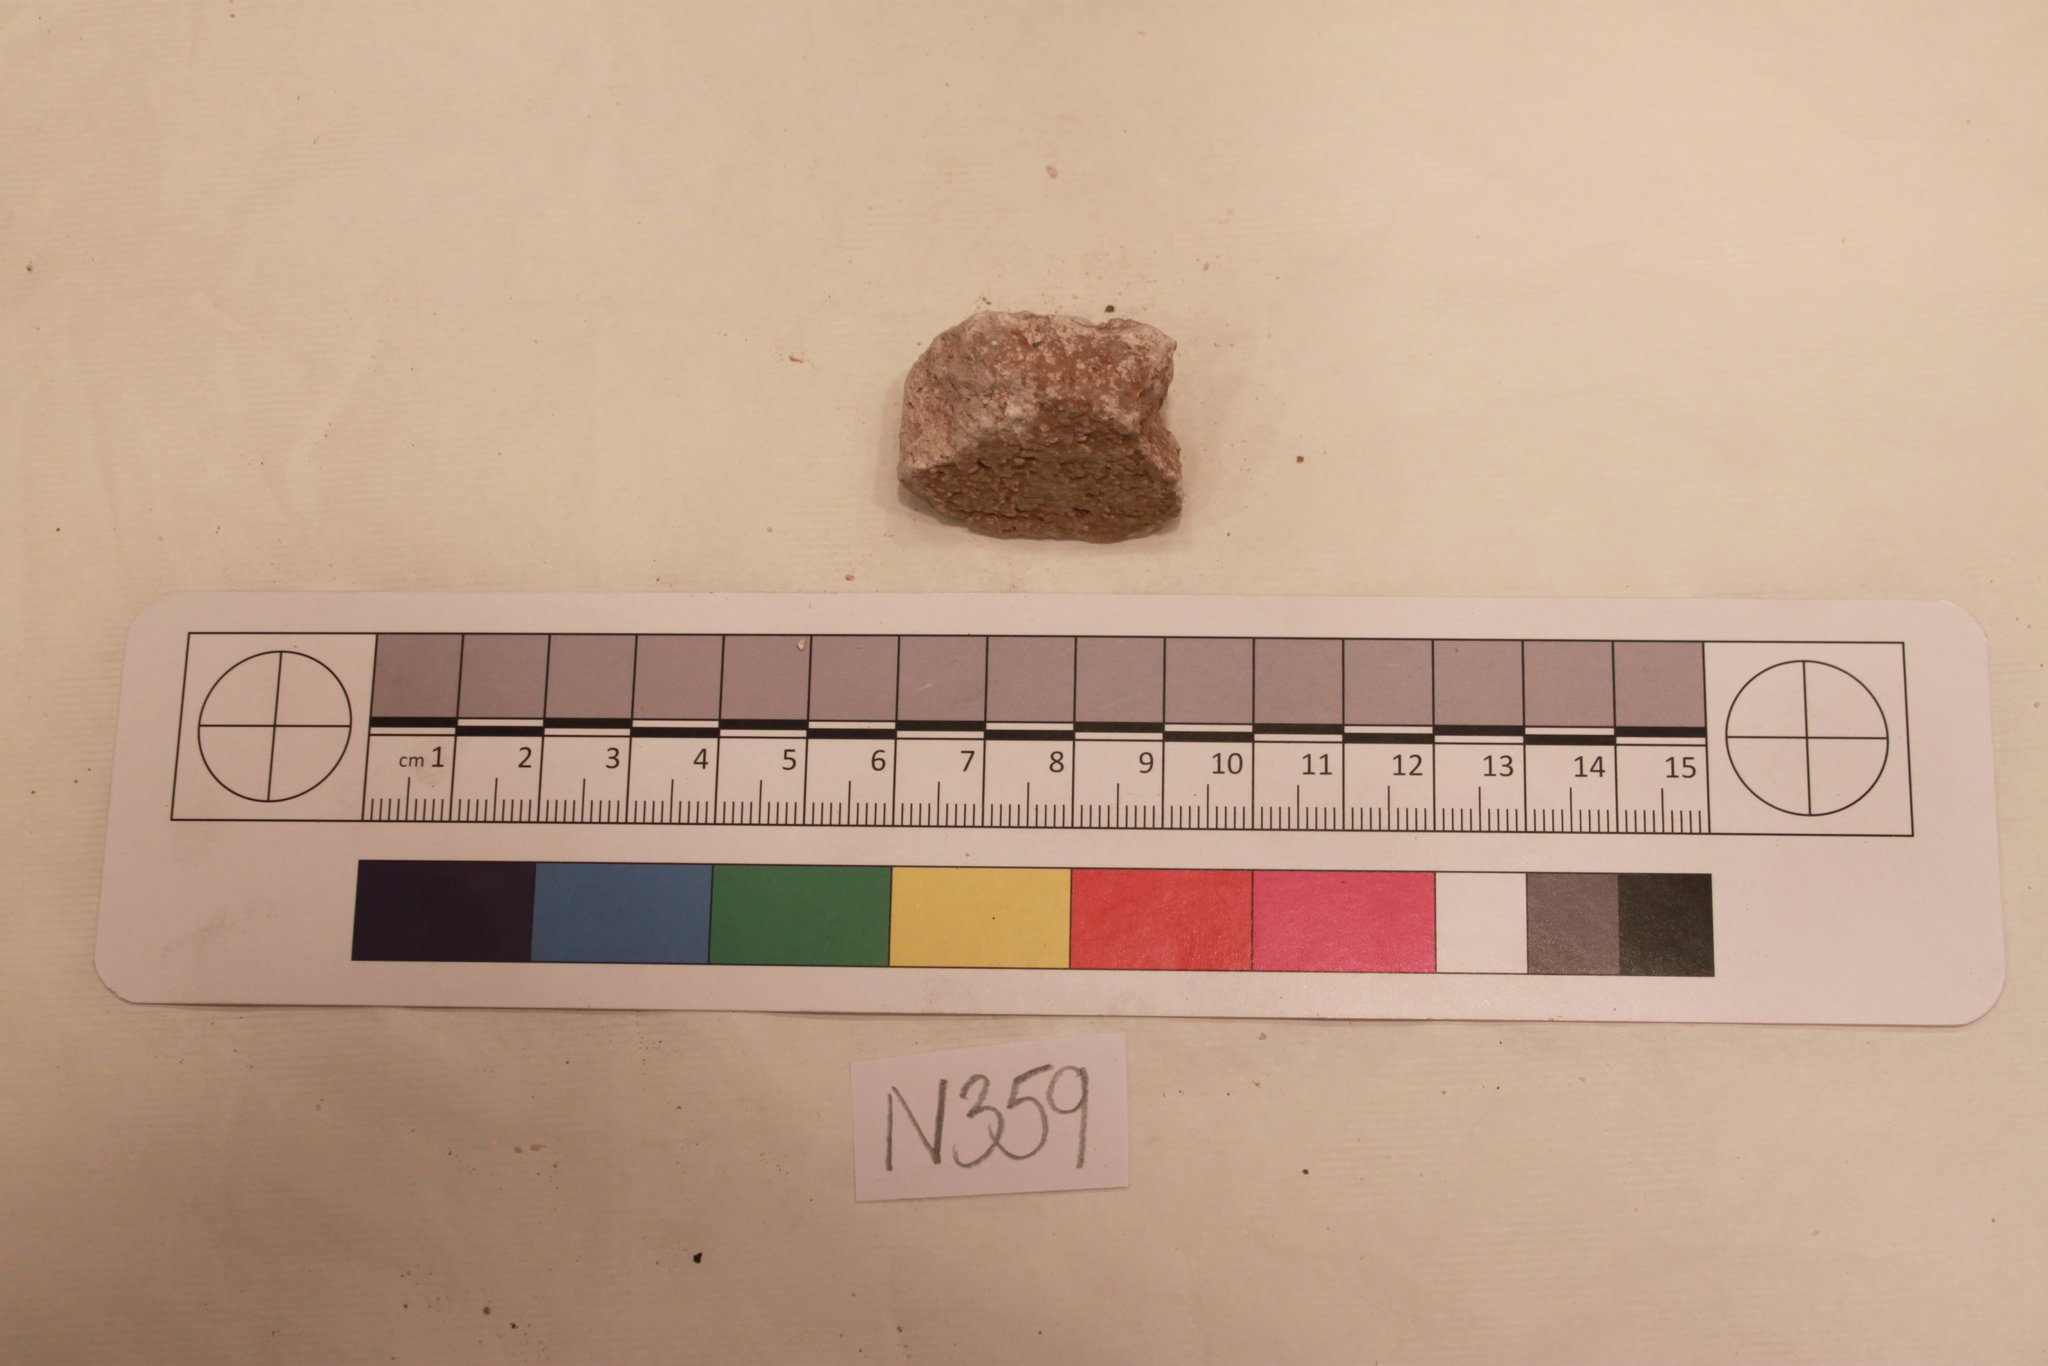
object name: fragment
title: Stucco Fragment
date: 701-1200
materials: plaster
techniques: carving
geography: iran